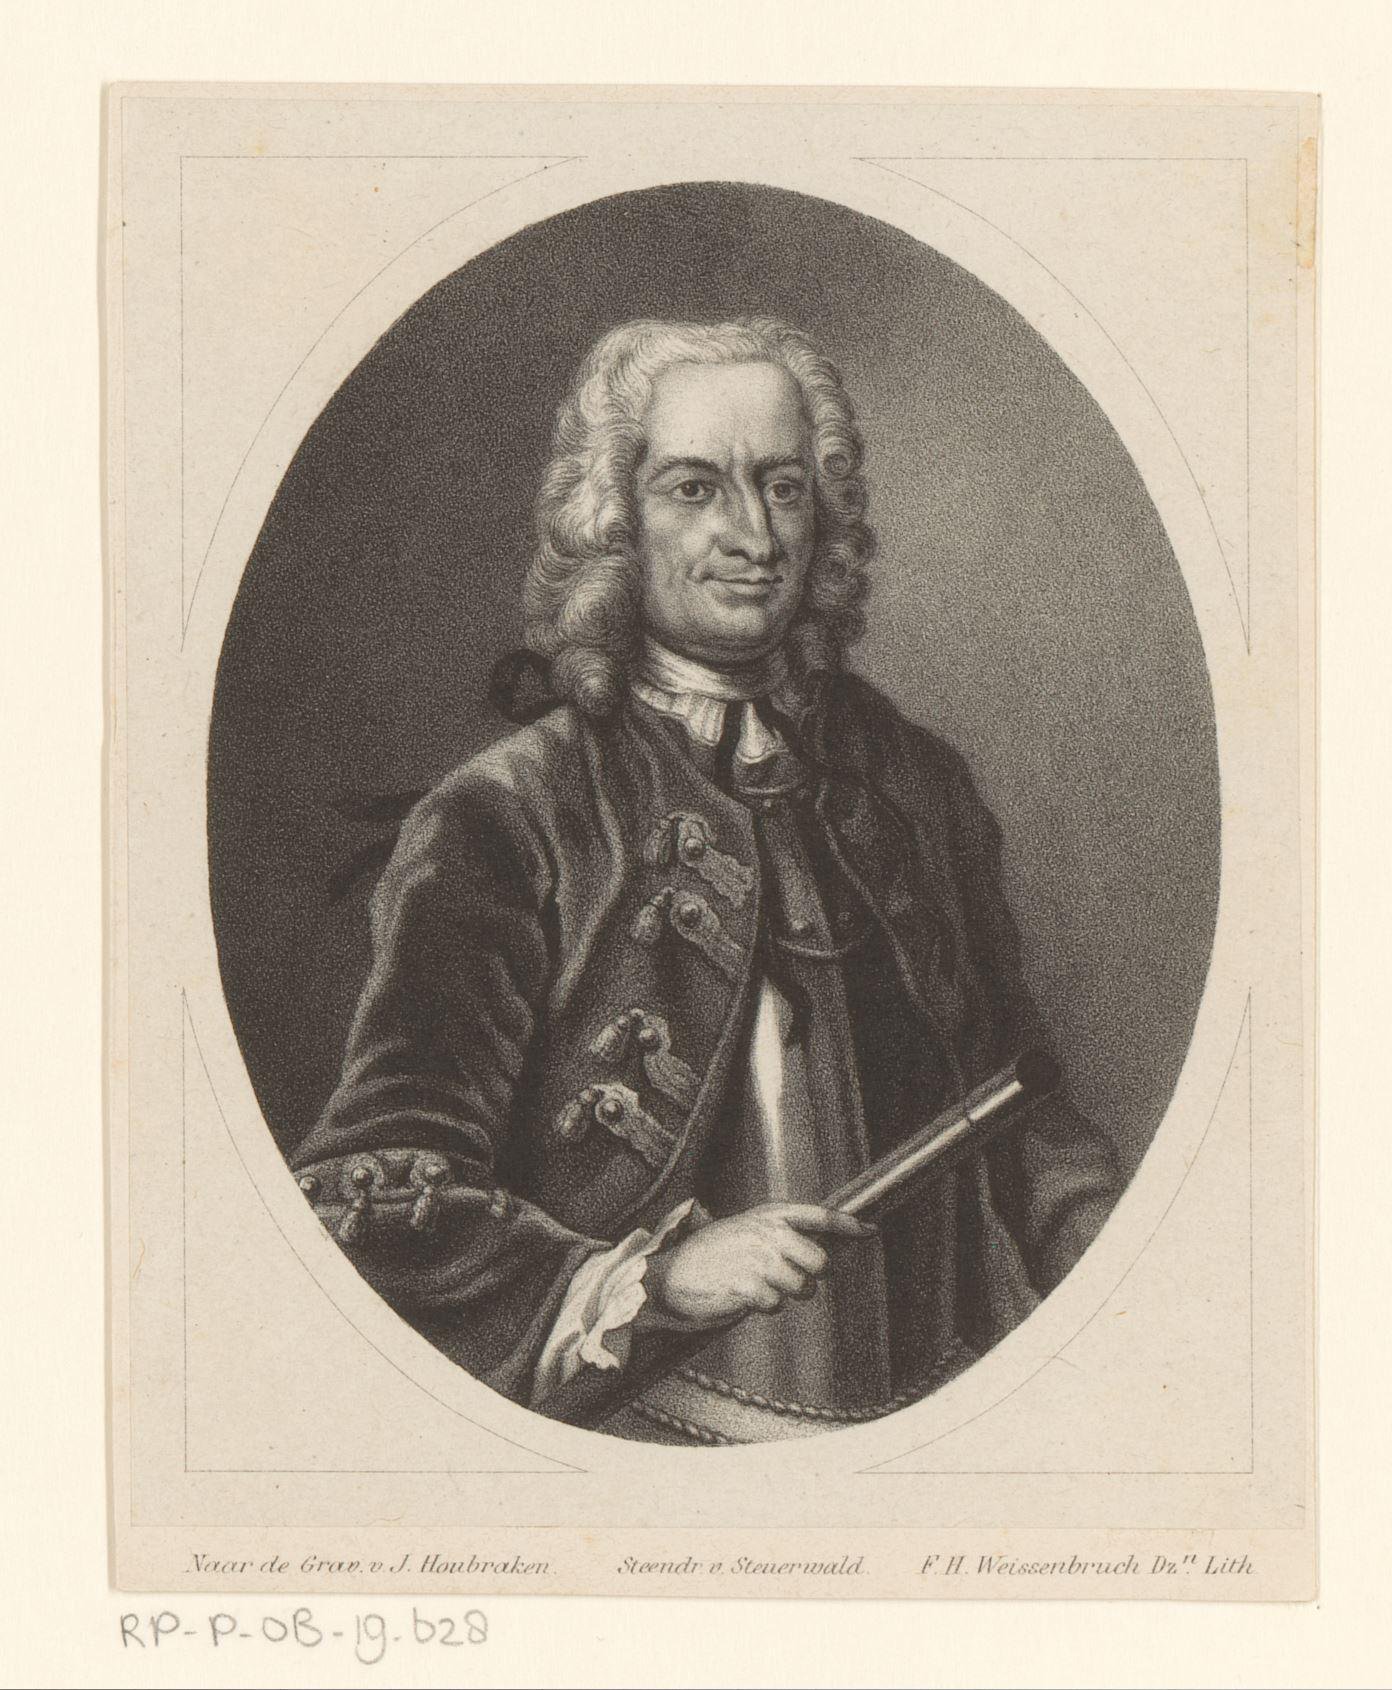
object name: book illustration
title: Portret van Cornelis Schrijver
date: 1858-1862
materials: paper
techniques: lithograph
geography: the hague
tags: amsterdam, historical persons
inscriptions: collector's mark: Lugt 2228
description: Prent uit: Jonge, J.C. de. Geschiedenis van het Nederlandsche zeewezen. Haarlem: Jonge, J.K.J. de, 1858-62.